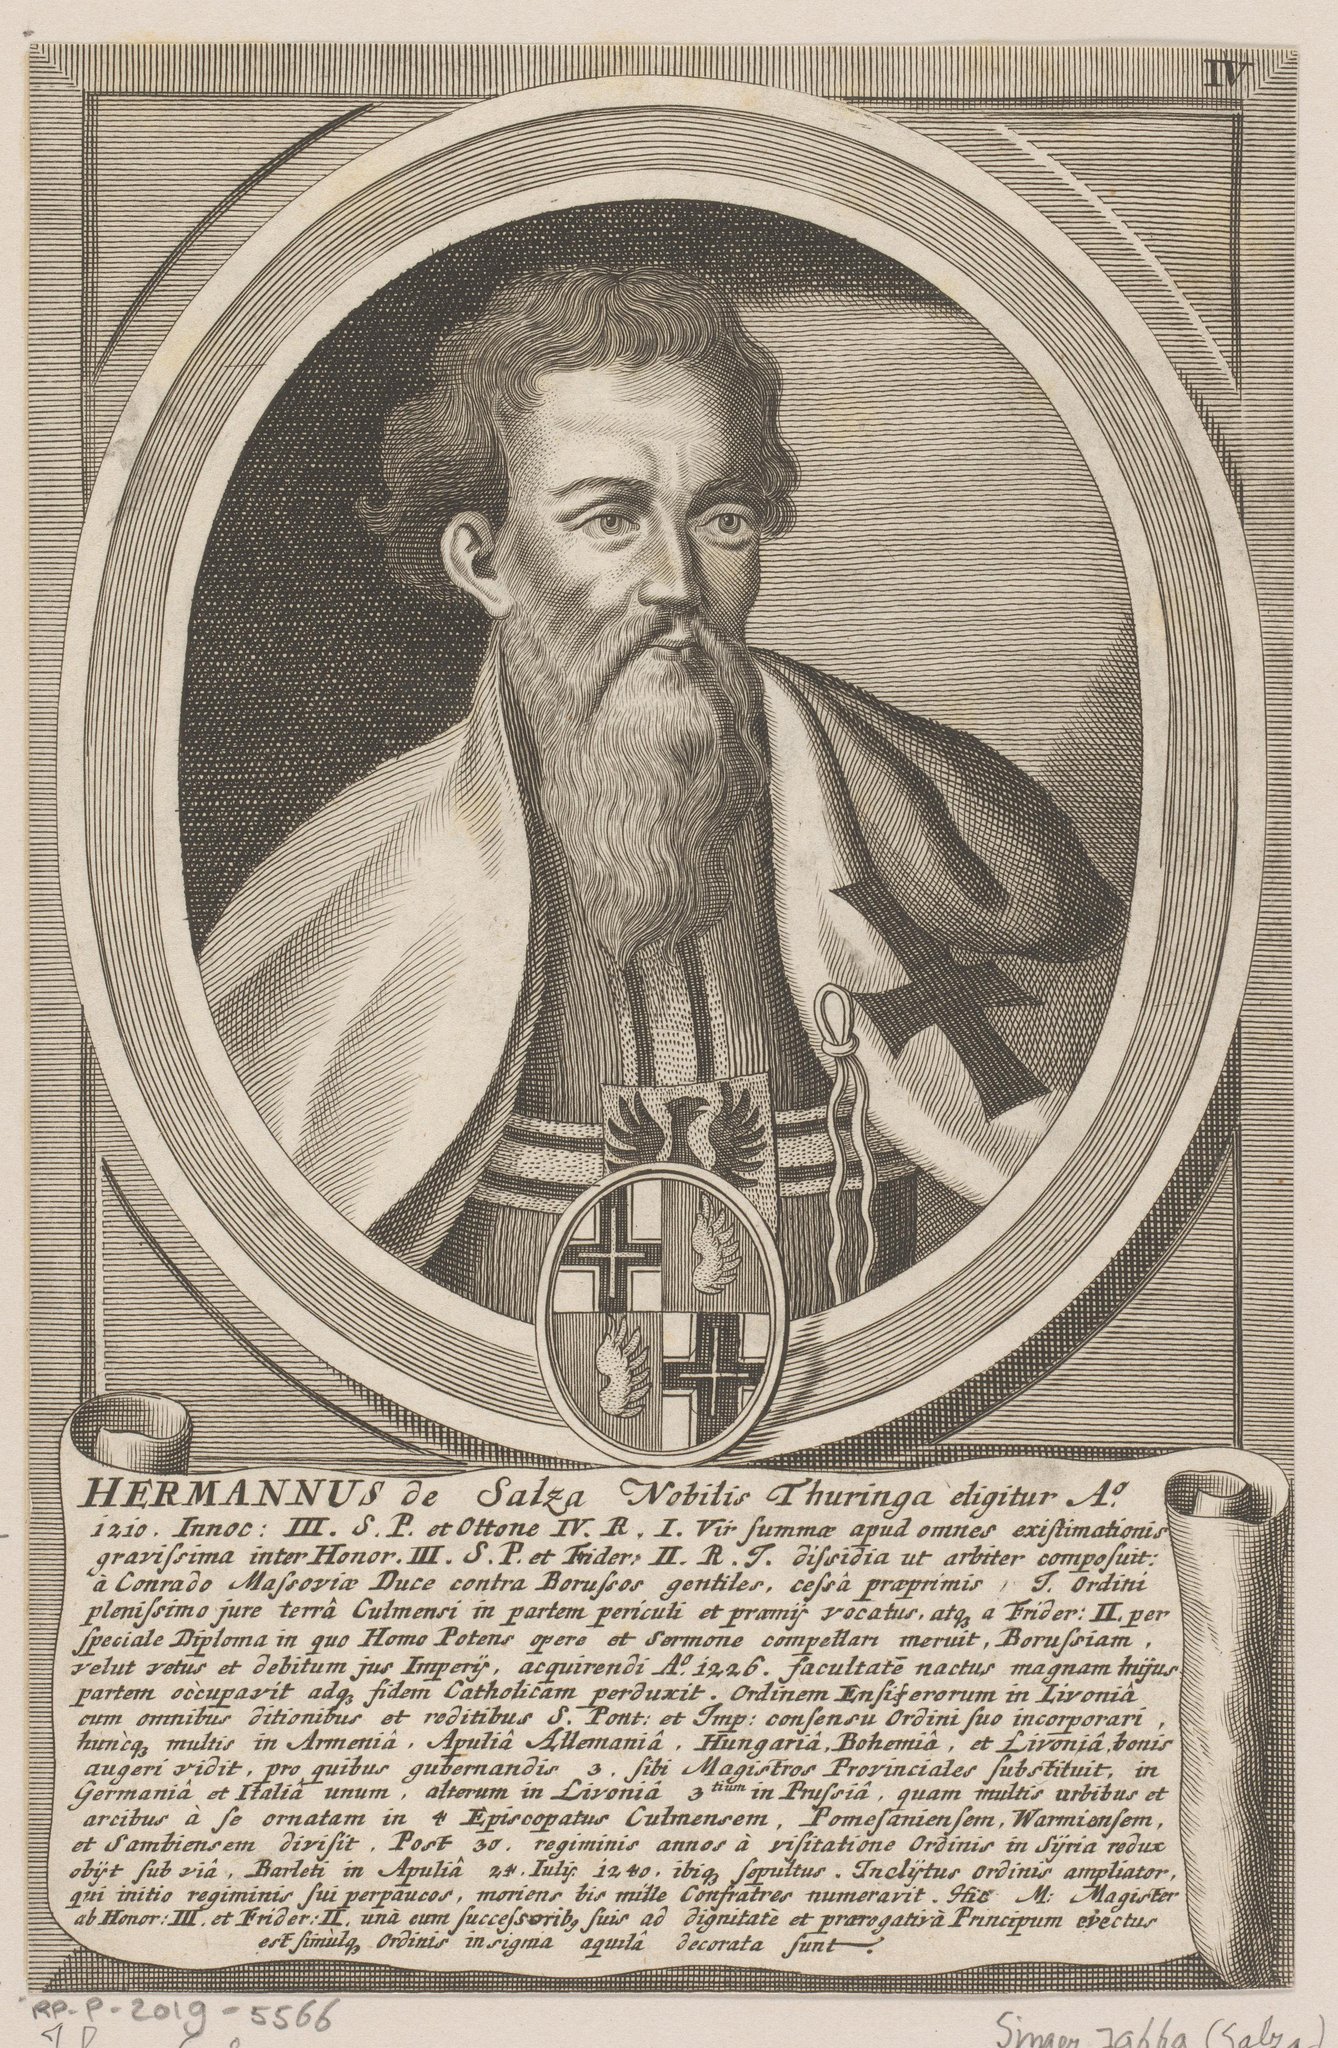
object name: print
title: Hermannus de Salza Nobilis Thuringa (...)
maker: johann salver (i)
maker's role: print maker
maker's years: 1670-1738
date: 1720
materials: paper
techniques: engraving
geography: würzburg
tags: knighthood order: teutonic order - insignia of a knighthood order, e.g.: badge, chain (with name of order), historical persons, armorial bearing, heraldry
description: Prent uit: [Salver, Johann]. De origine, secundis et adversis successibus, nec non de statu moderno inclyti ordinis equestris hospitalis b.m.v. Teutonicorum in Jerusalem. Würzburg: Johann Salver, [ca. 1720].